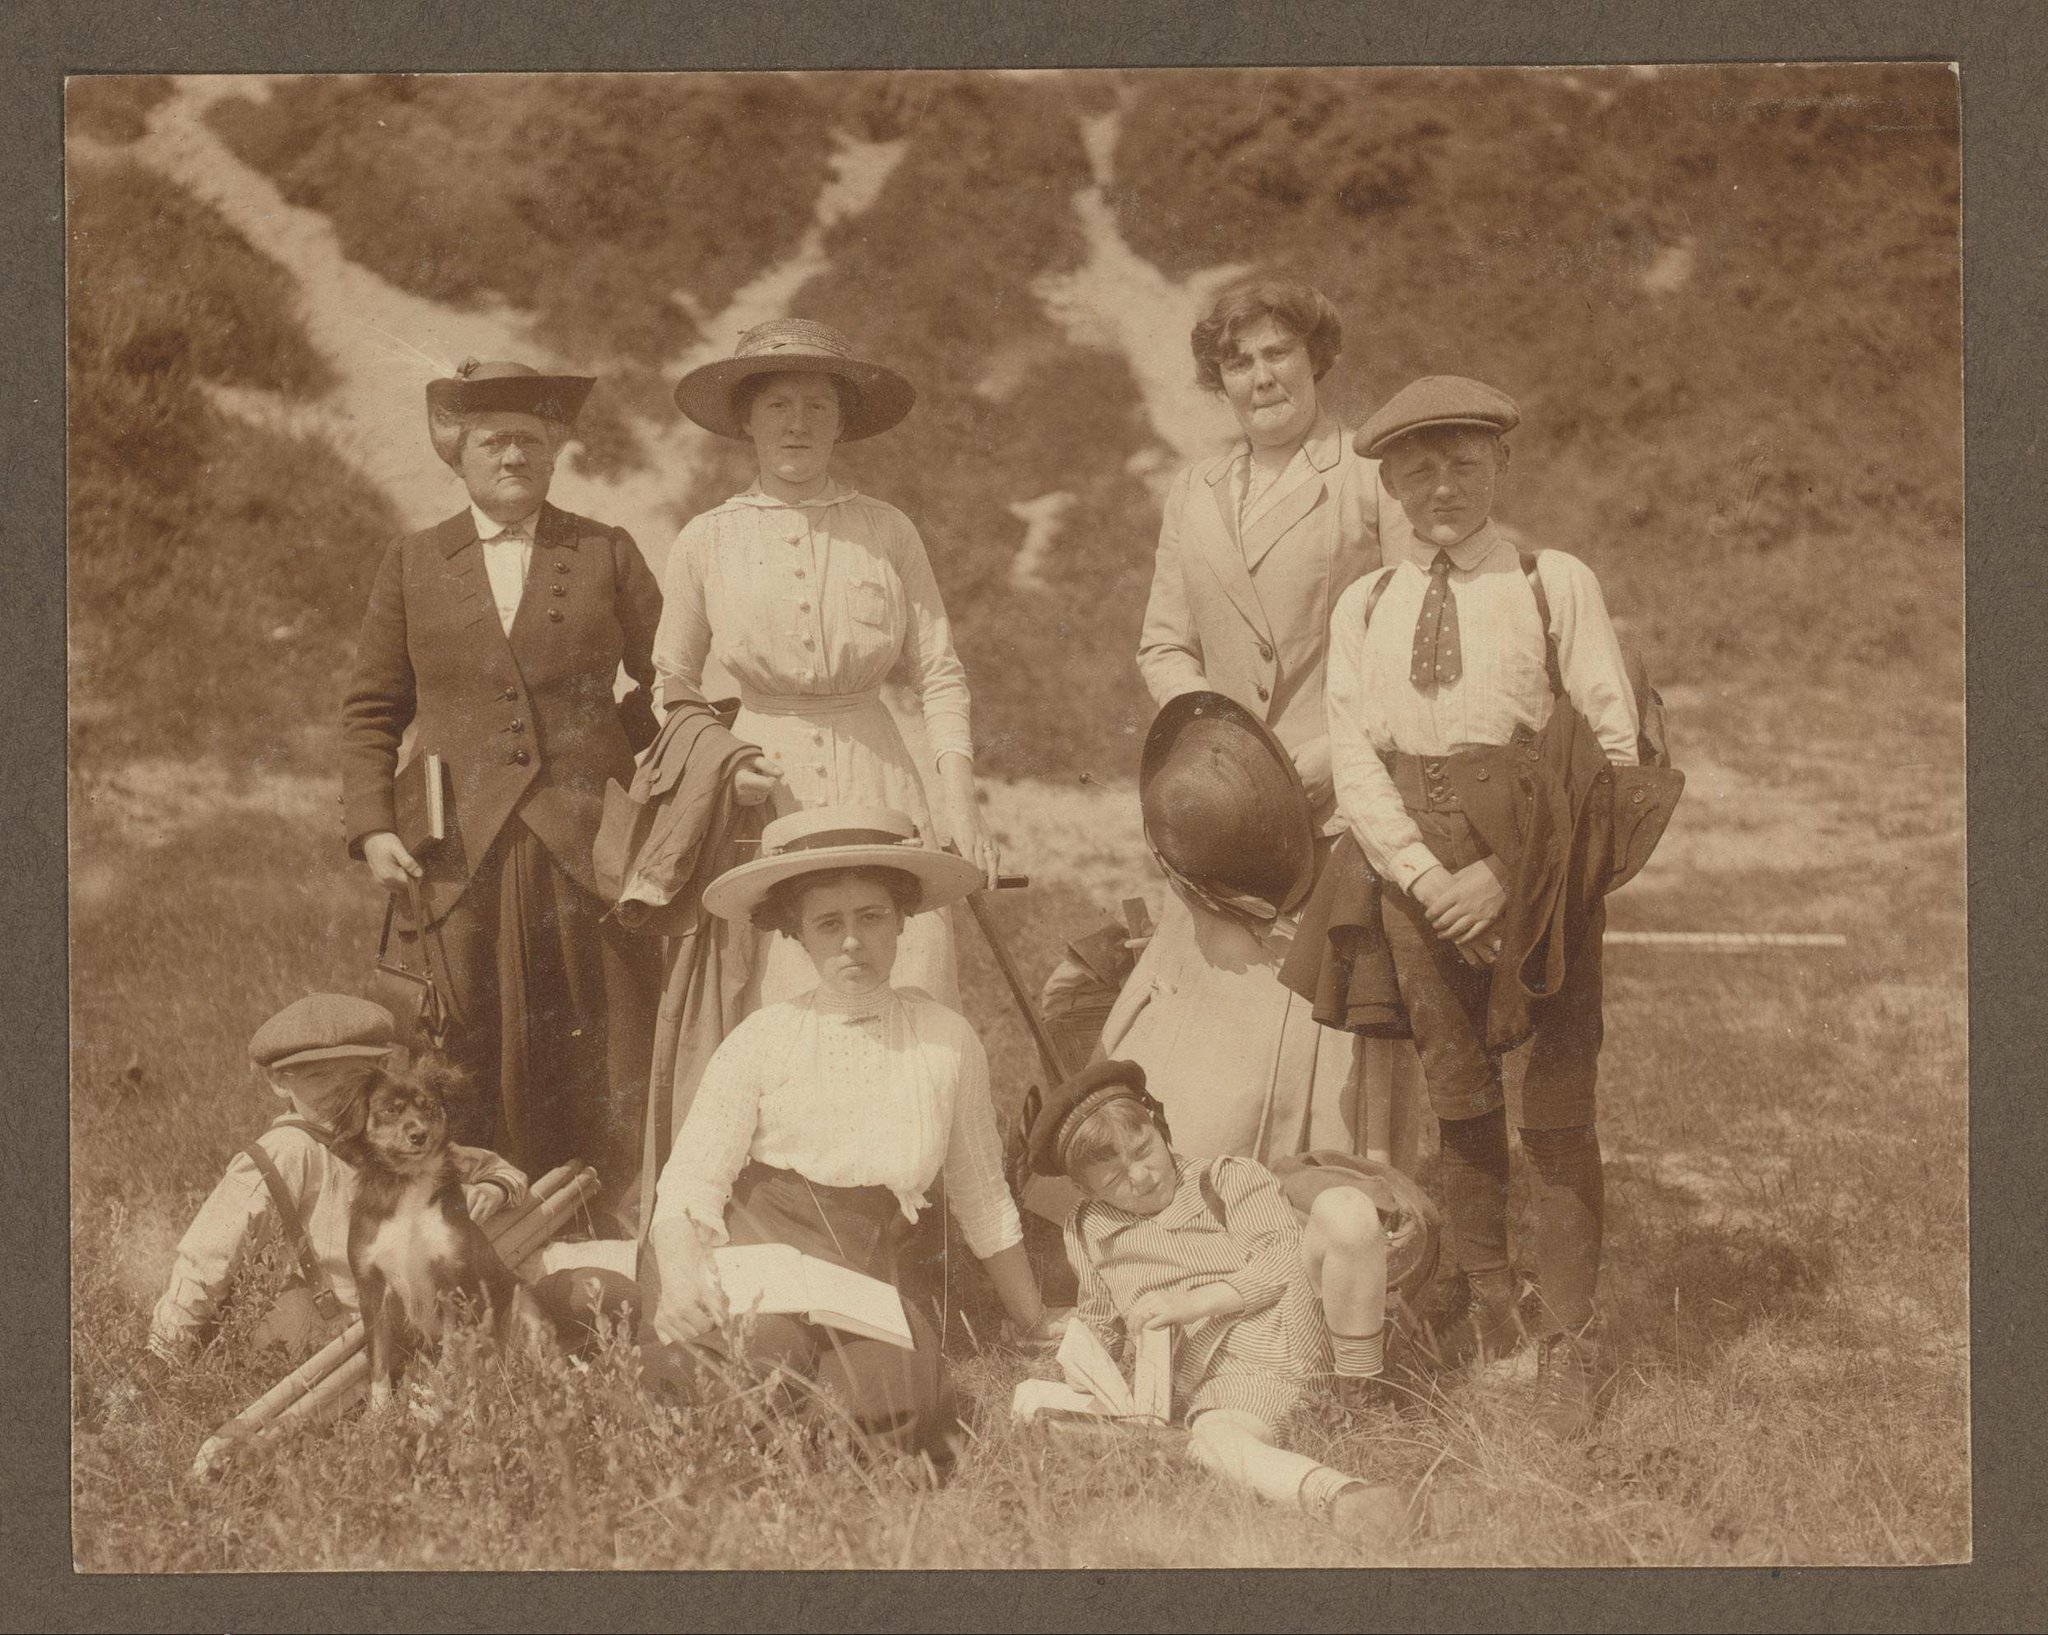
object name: album leaf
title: Groepsportret van zeven leden van de familie Vermeulen met hond in de duinen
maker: cornelis johannes lodewicus vermeulen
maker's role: fotograaf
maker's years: 1861-1936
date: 1910-1915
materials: photographic support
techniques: gelatin silver print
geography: netherlands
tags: dunes (sea not visible); in the dunes, family life, dog